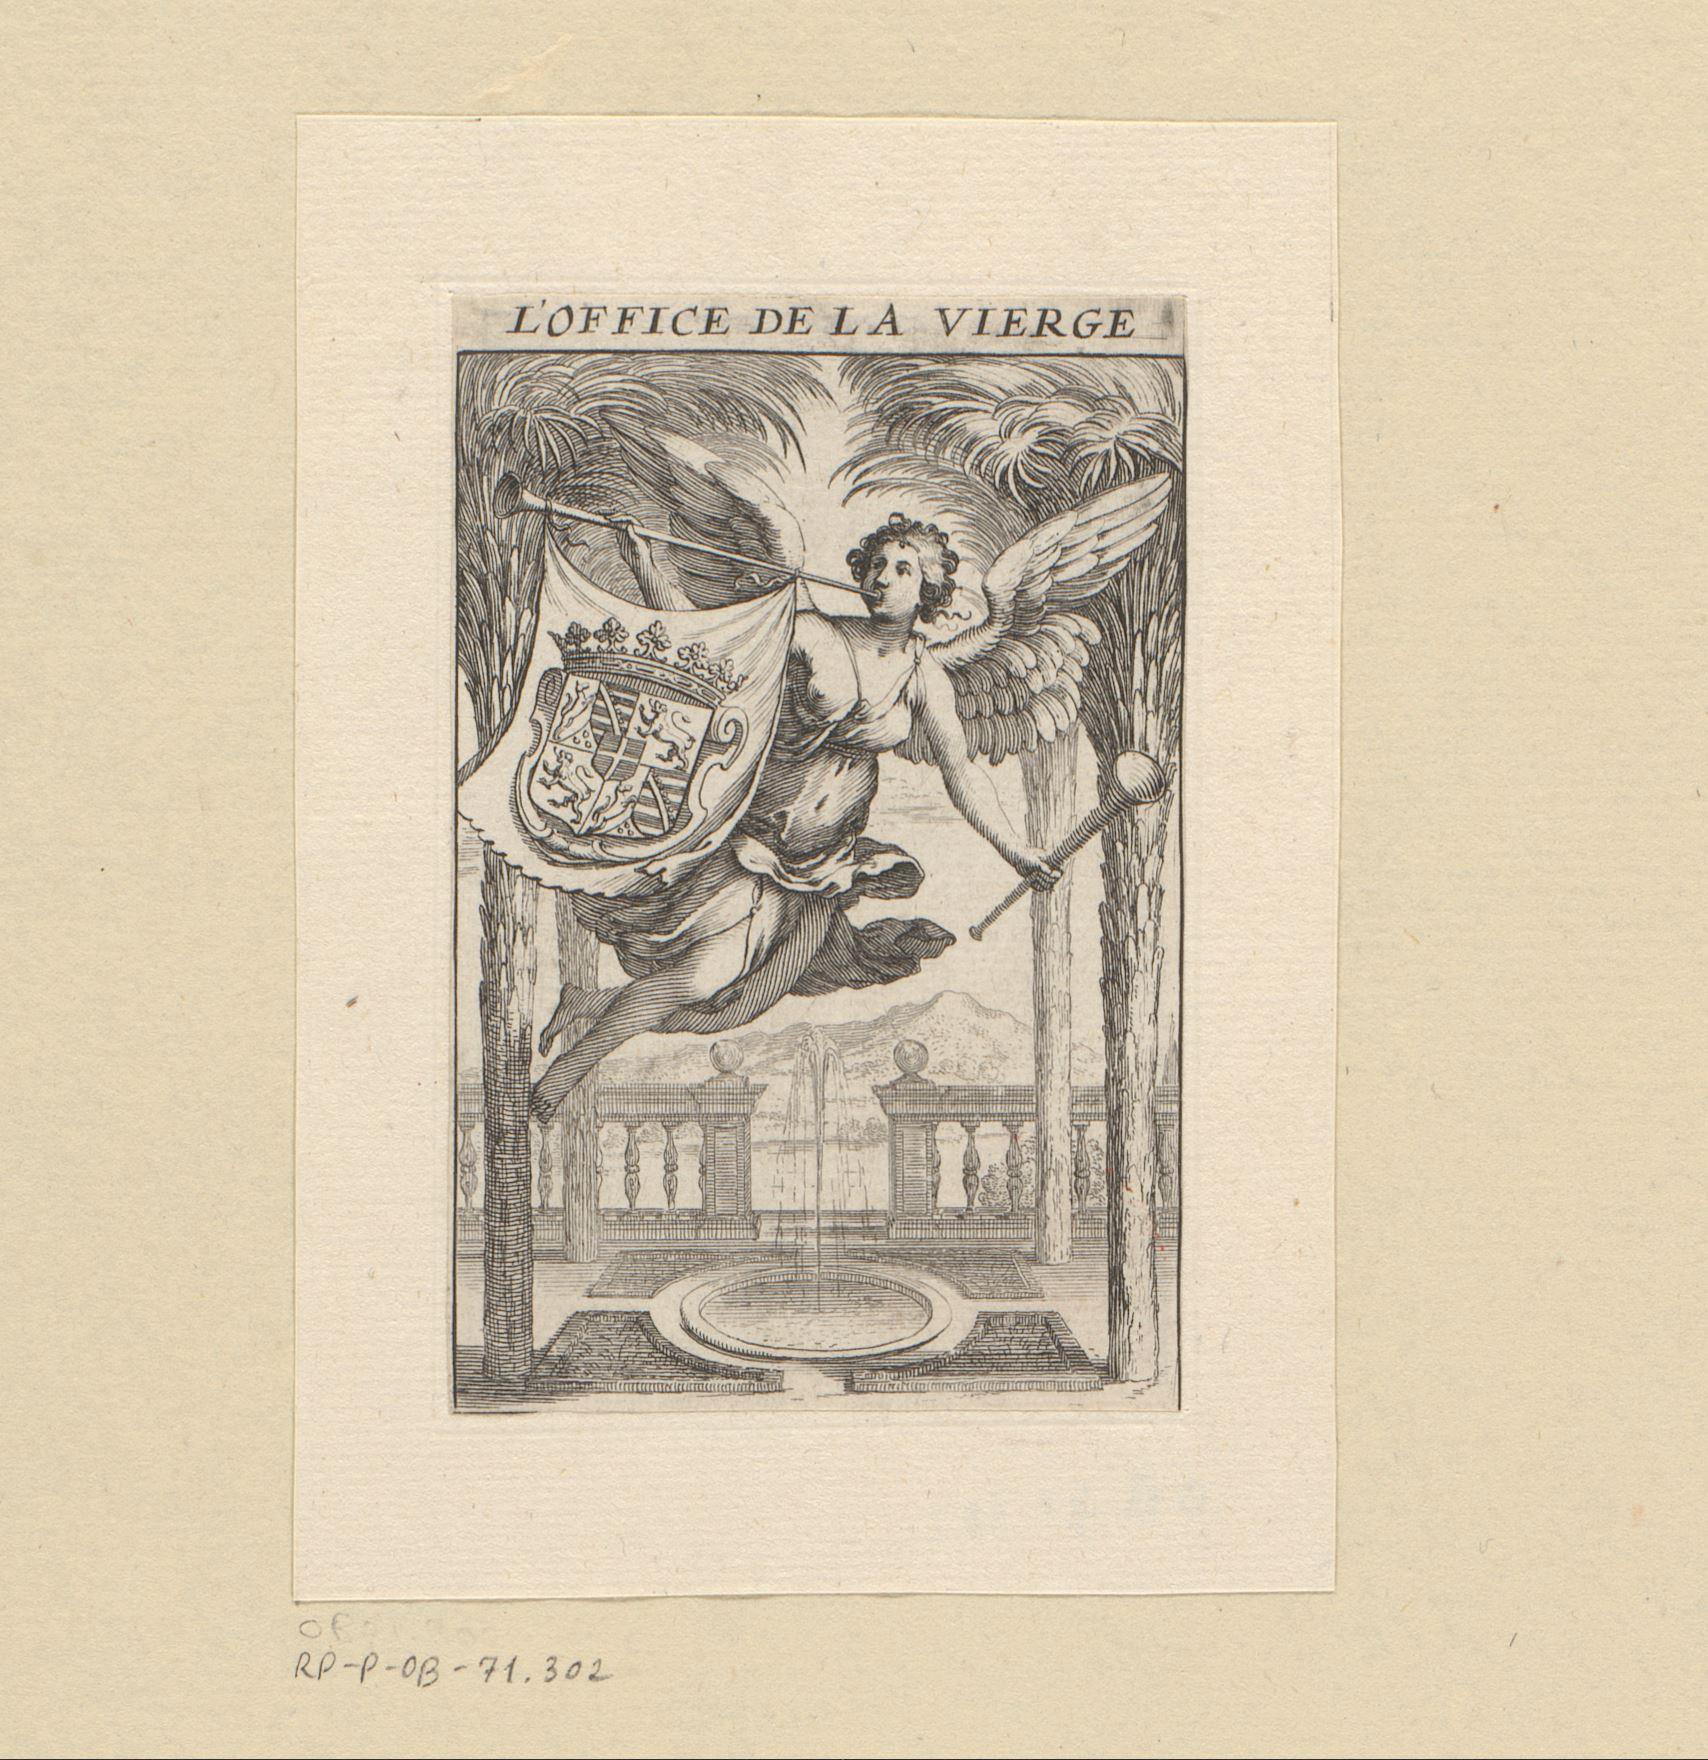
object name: print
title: L'Office de la Vierge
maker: claude mellan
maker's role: draughtsman, print maker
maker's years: 1598-1688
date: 1608-1688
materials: paper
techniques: engraving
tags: angels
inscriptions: collector's mark: Lugt 240